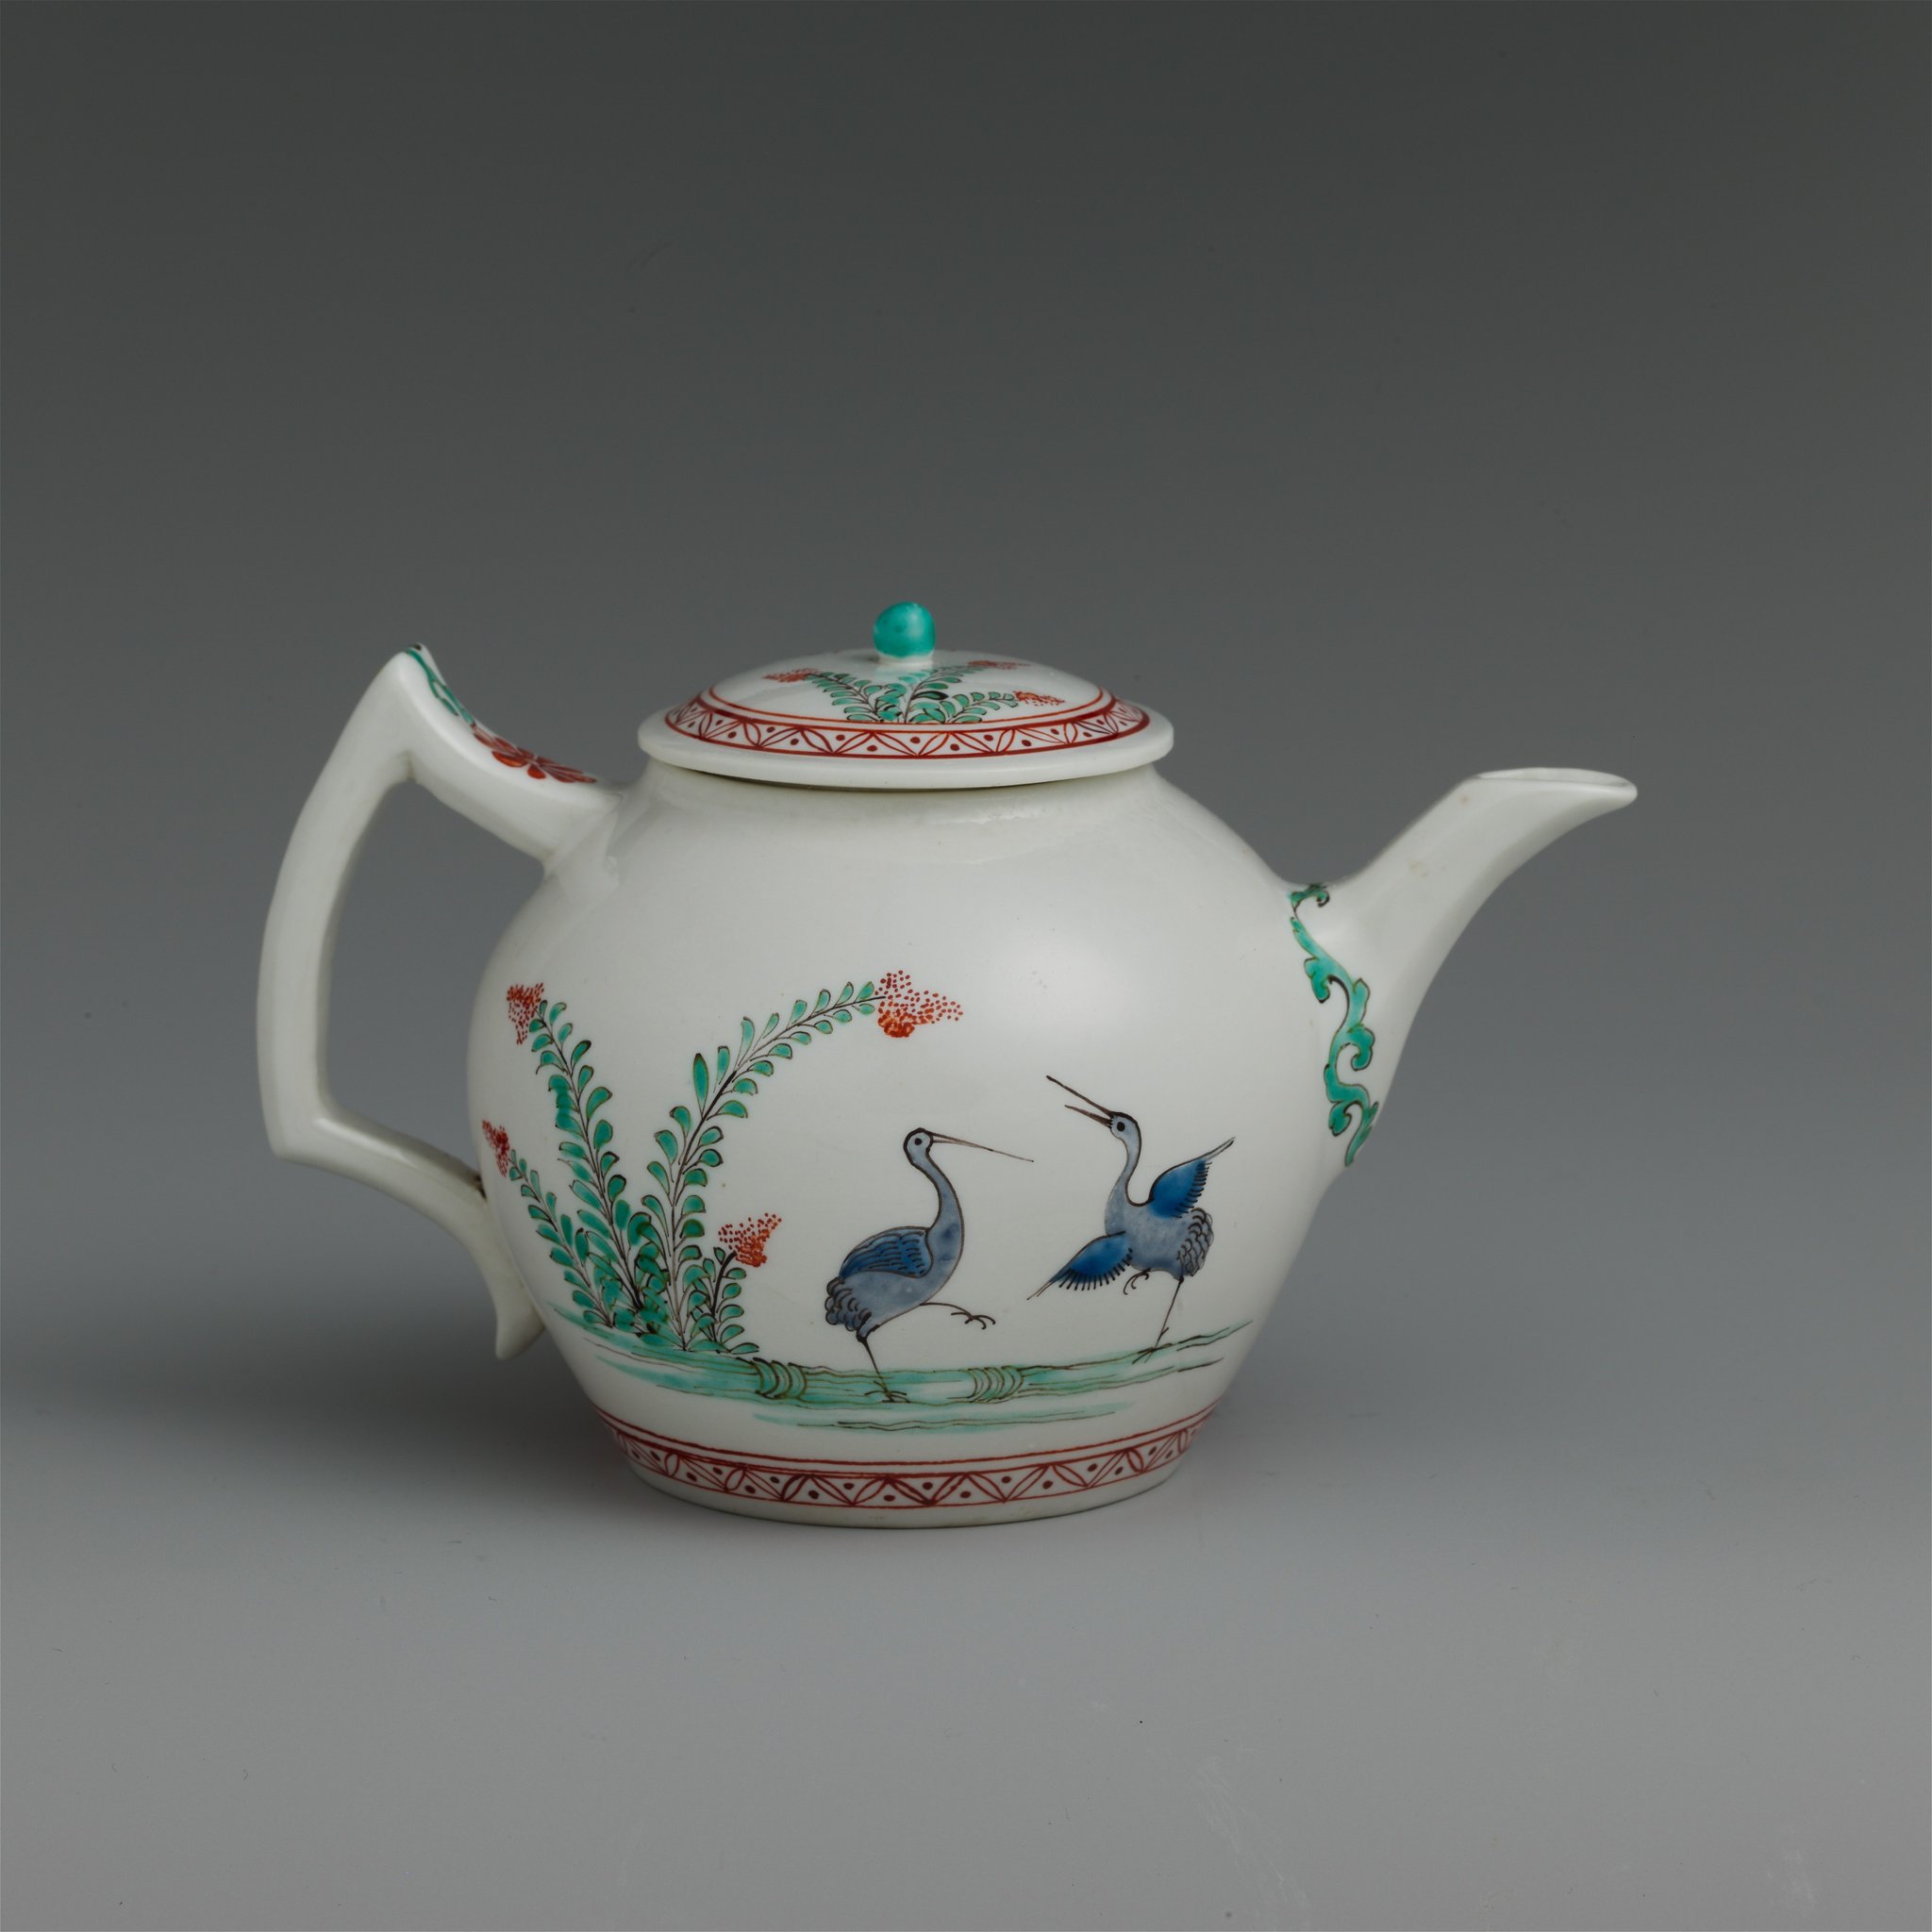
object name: teapot with cover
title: Teapot with storks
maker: chantilly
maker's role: factory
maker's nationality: french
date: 1735-1740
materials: enamel, soft paste porcelain, glaze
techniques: painting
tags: birds,plants